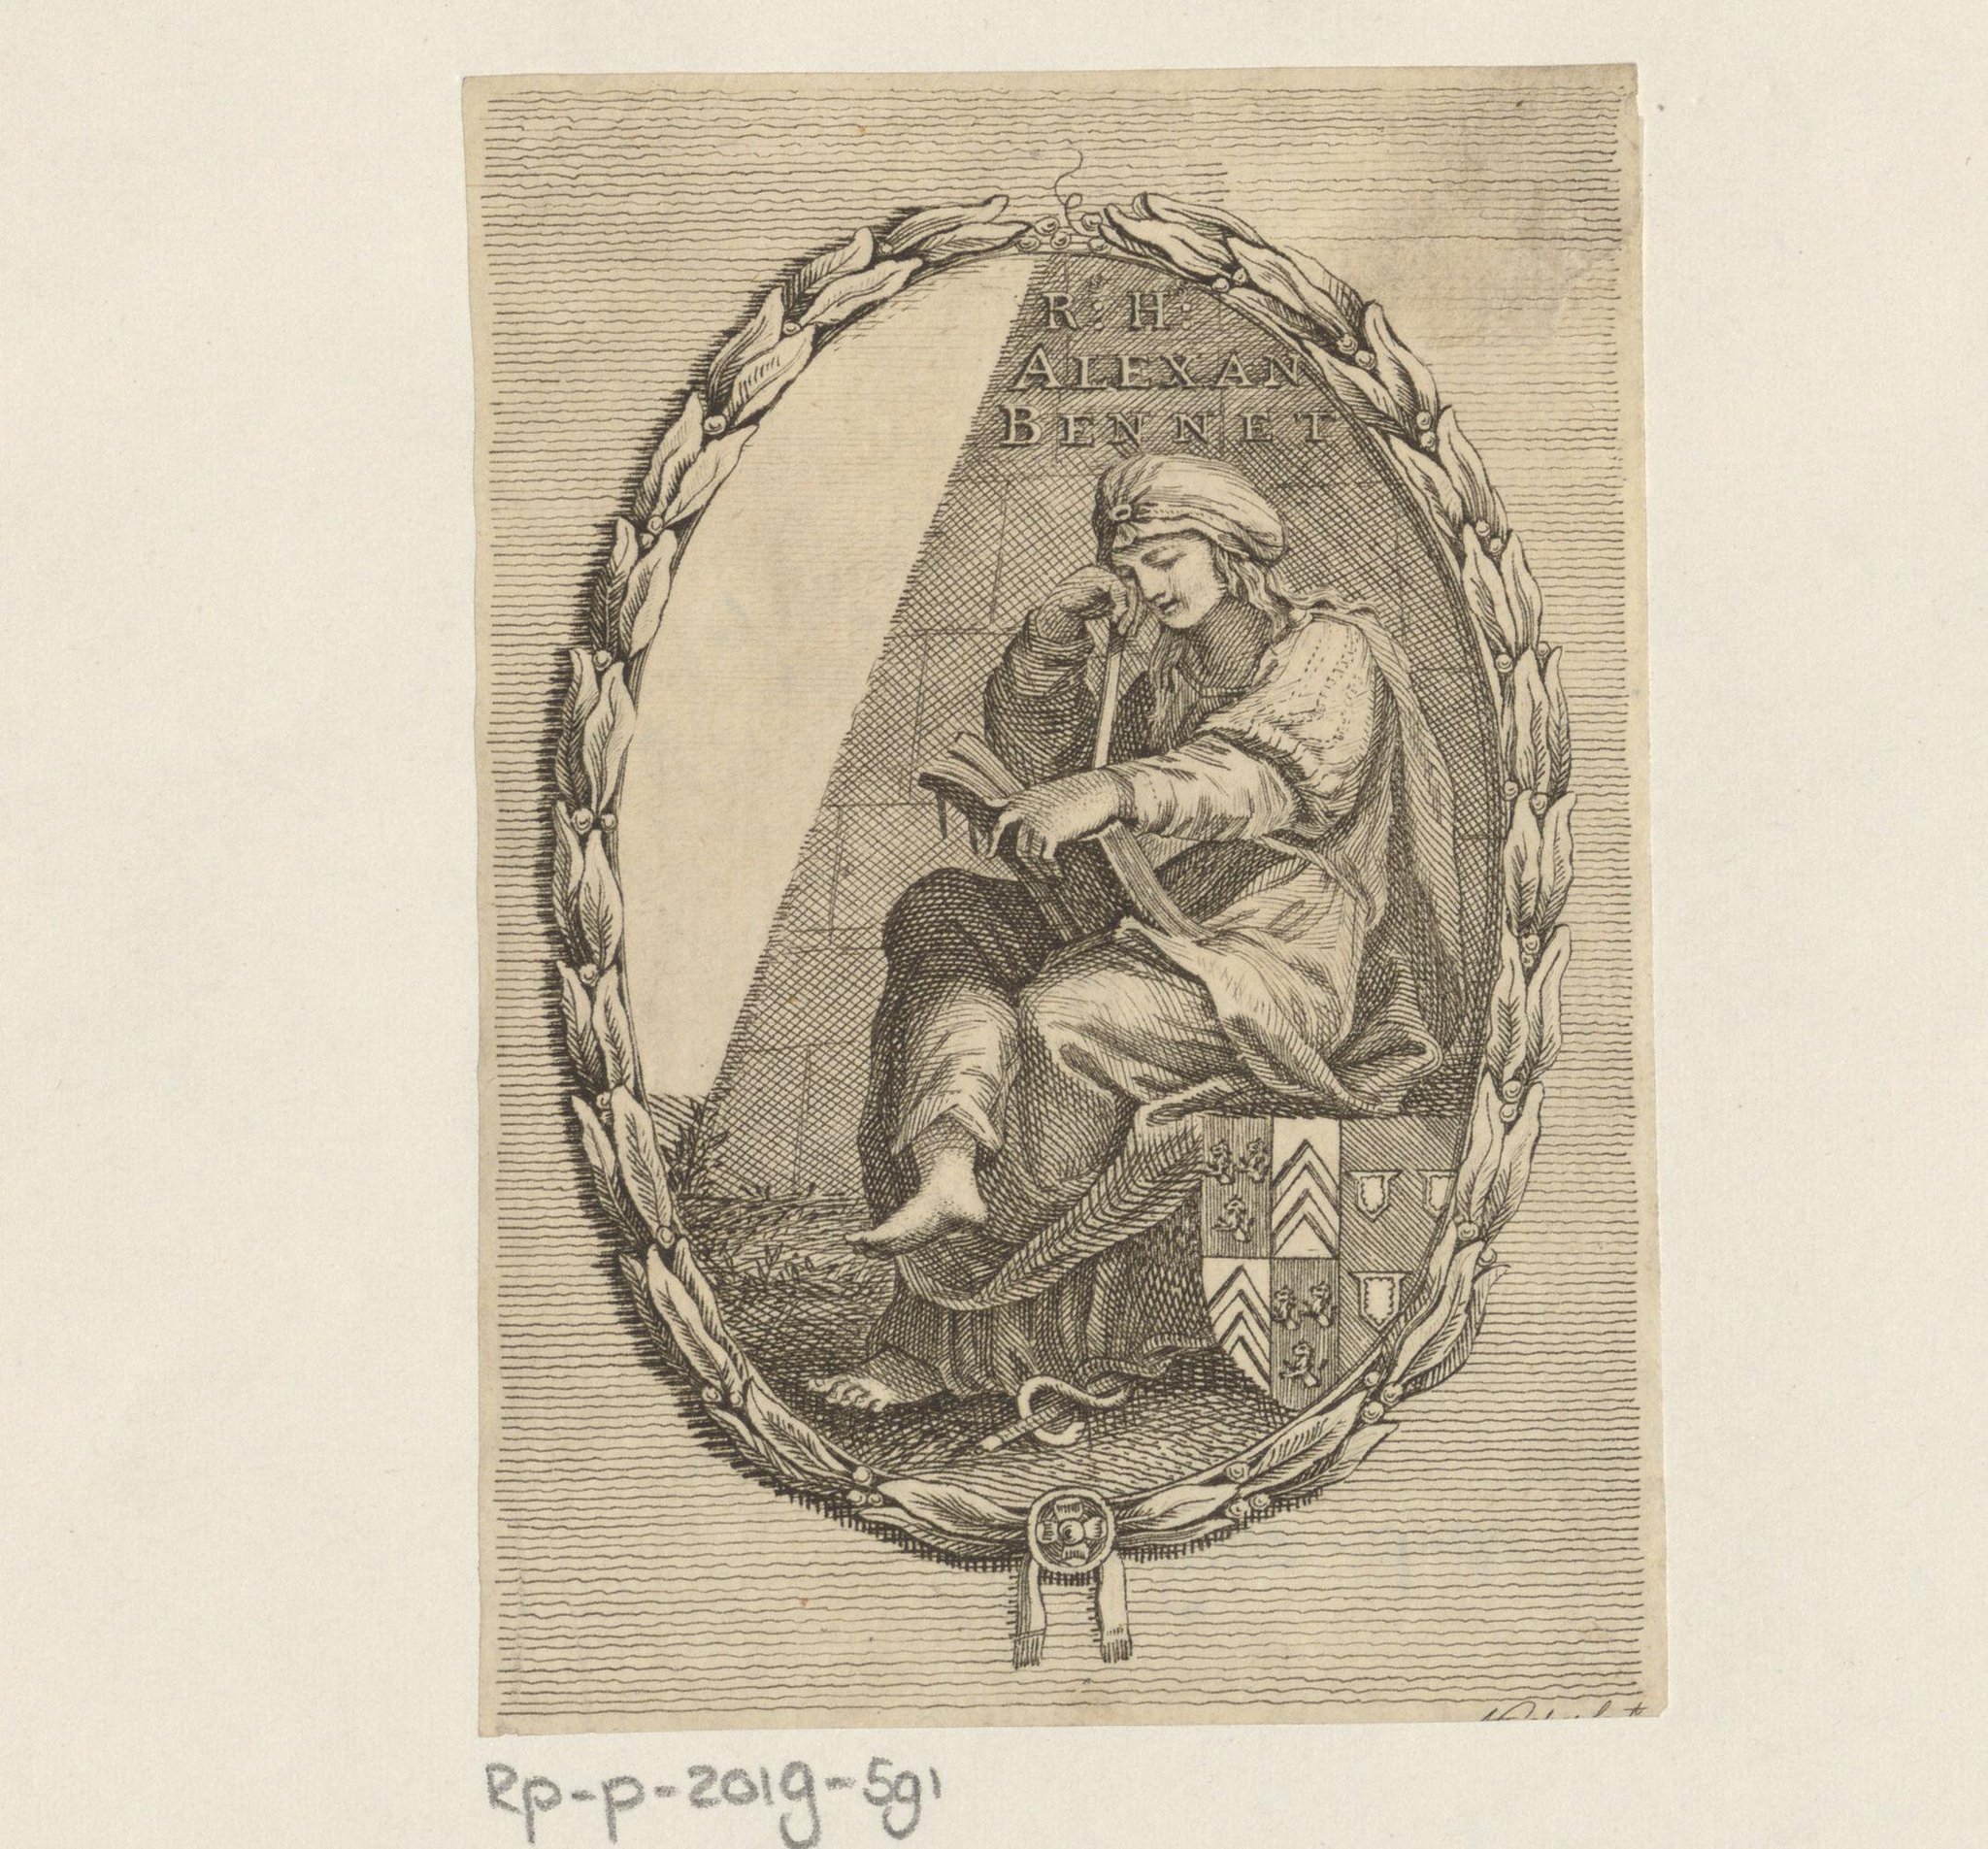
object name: bookplate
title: Ex libris van R. H. Alexan. Bennet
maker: r.b. hughes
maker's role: print maker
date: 1780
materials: paper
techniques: engraving, etching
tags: politician, aesculapian sign, armorial bearing, heraldry